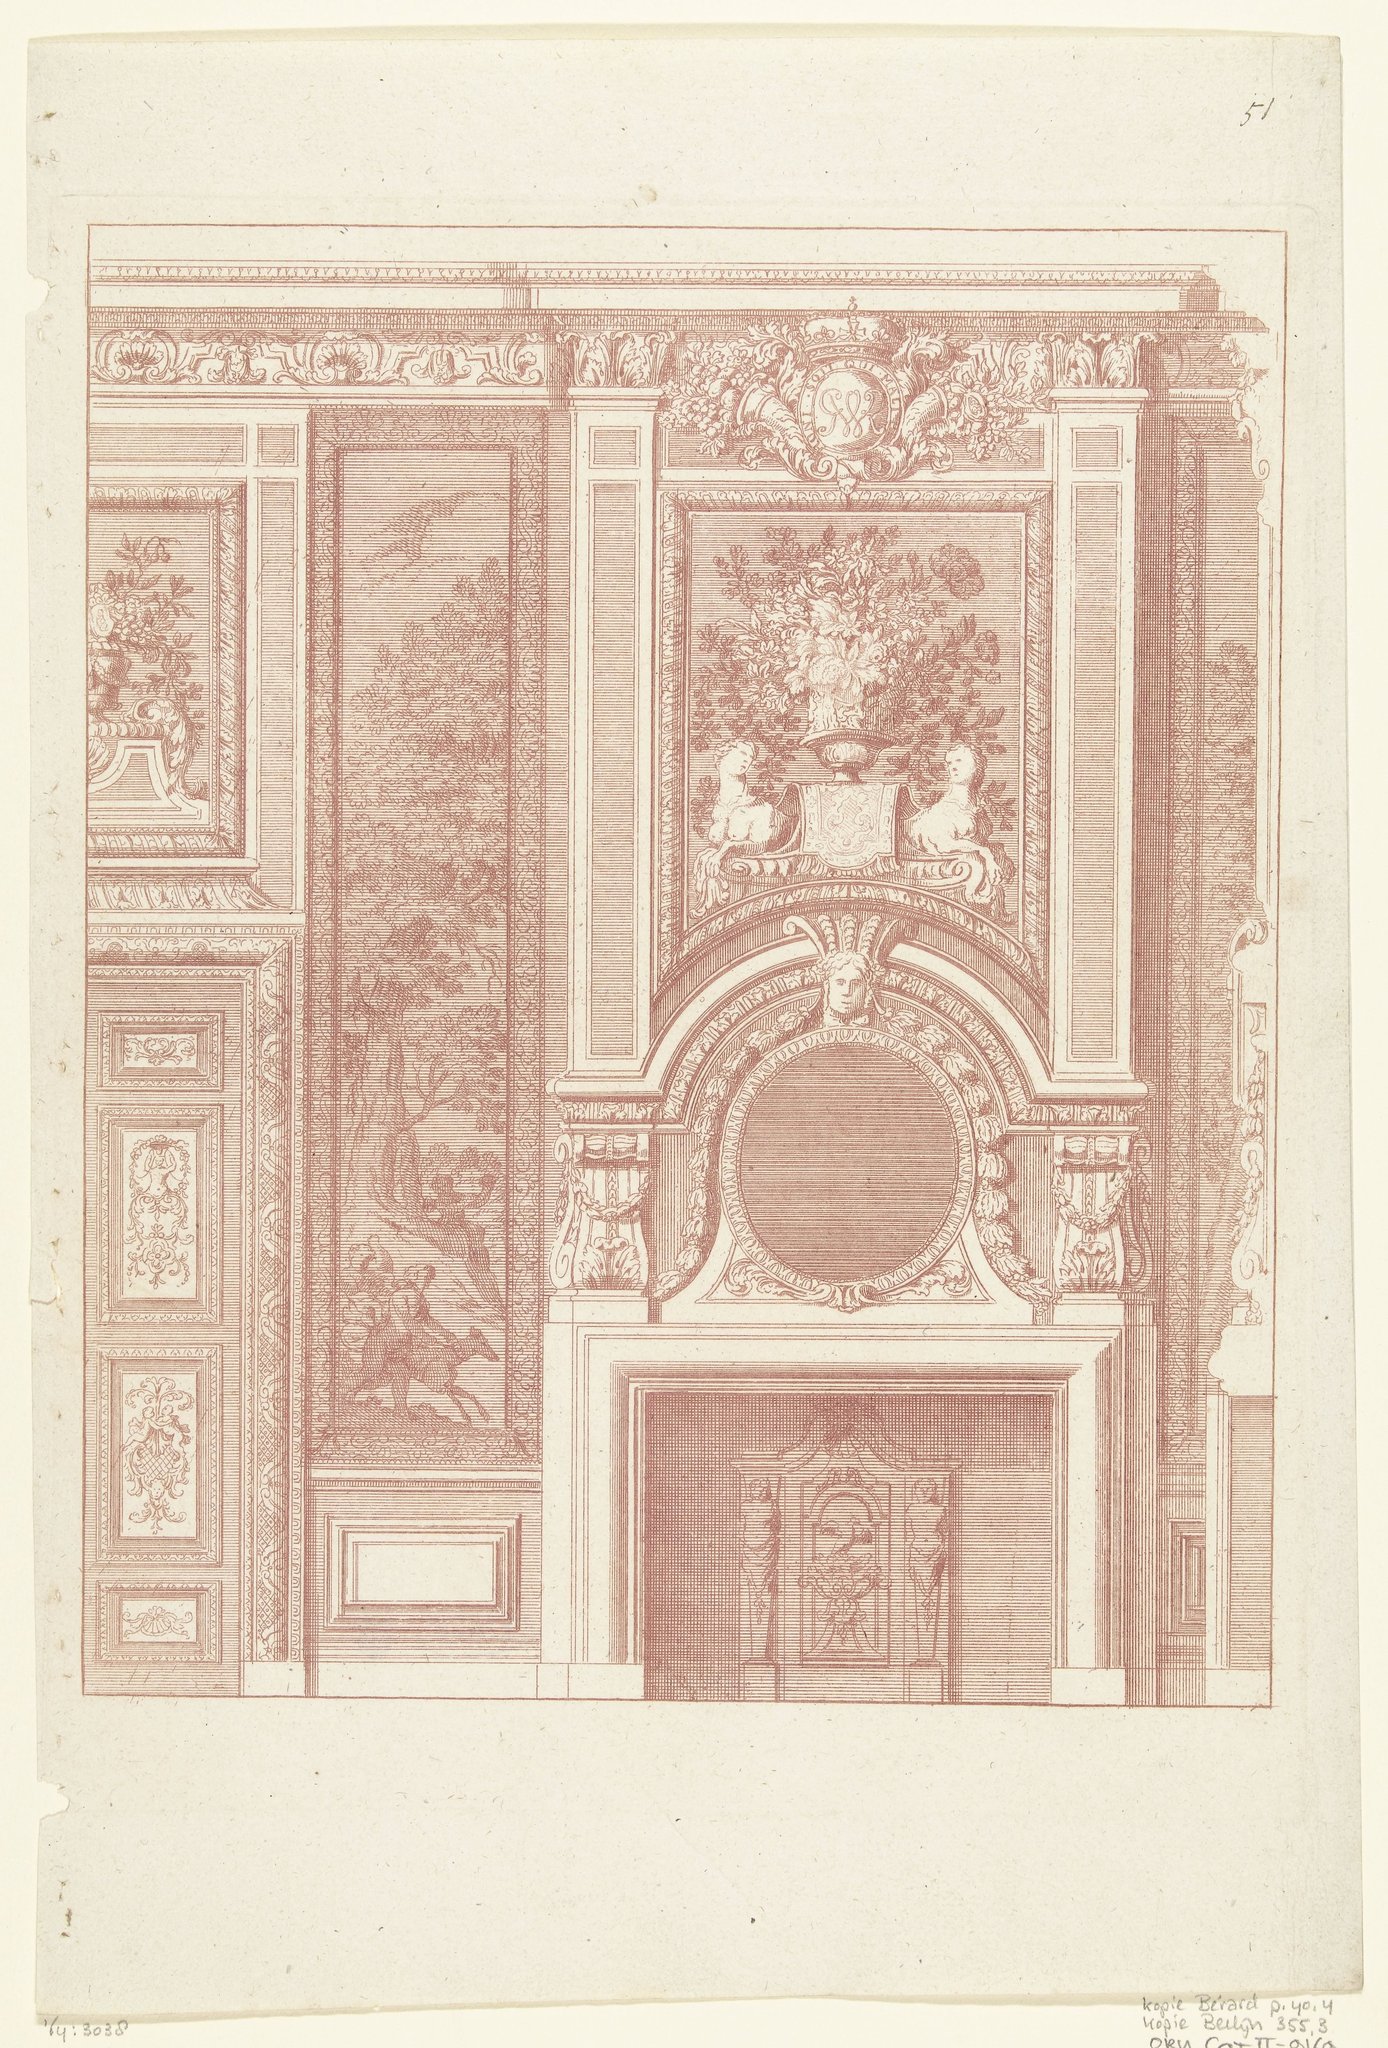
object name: print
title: Schouw voor een wand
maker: Anonymous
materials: paper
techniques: etching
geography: netherlands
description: Links is een halve deur zichtbaar met een bovendeurspaneel. Tussen de schoorsteenboezem en de gebogen kroonlijst hangt een spiegel, daarboven staat een vaas met bloemen. Helemaal bovenaan is het bekroonde monogram WR (William Rex) zichtbaar. Kopie naar prent uit de serie Nouvelles Cheminée faittes en plusieur en droits de la Hollande et autres Prouinces.